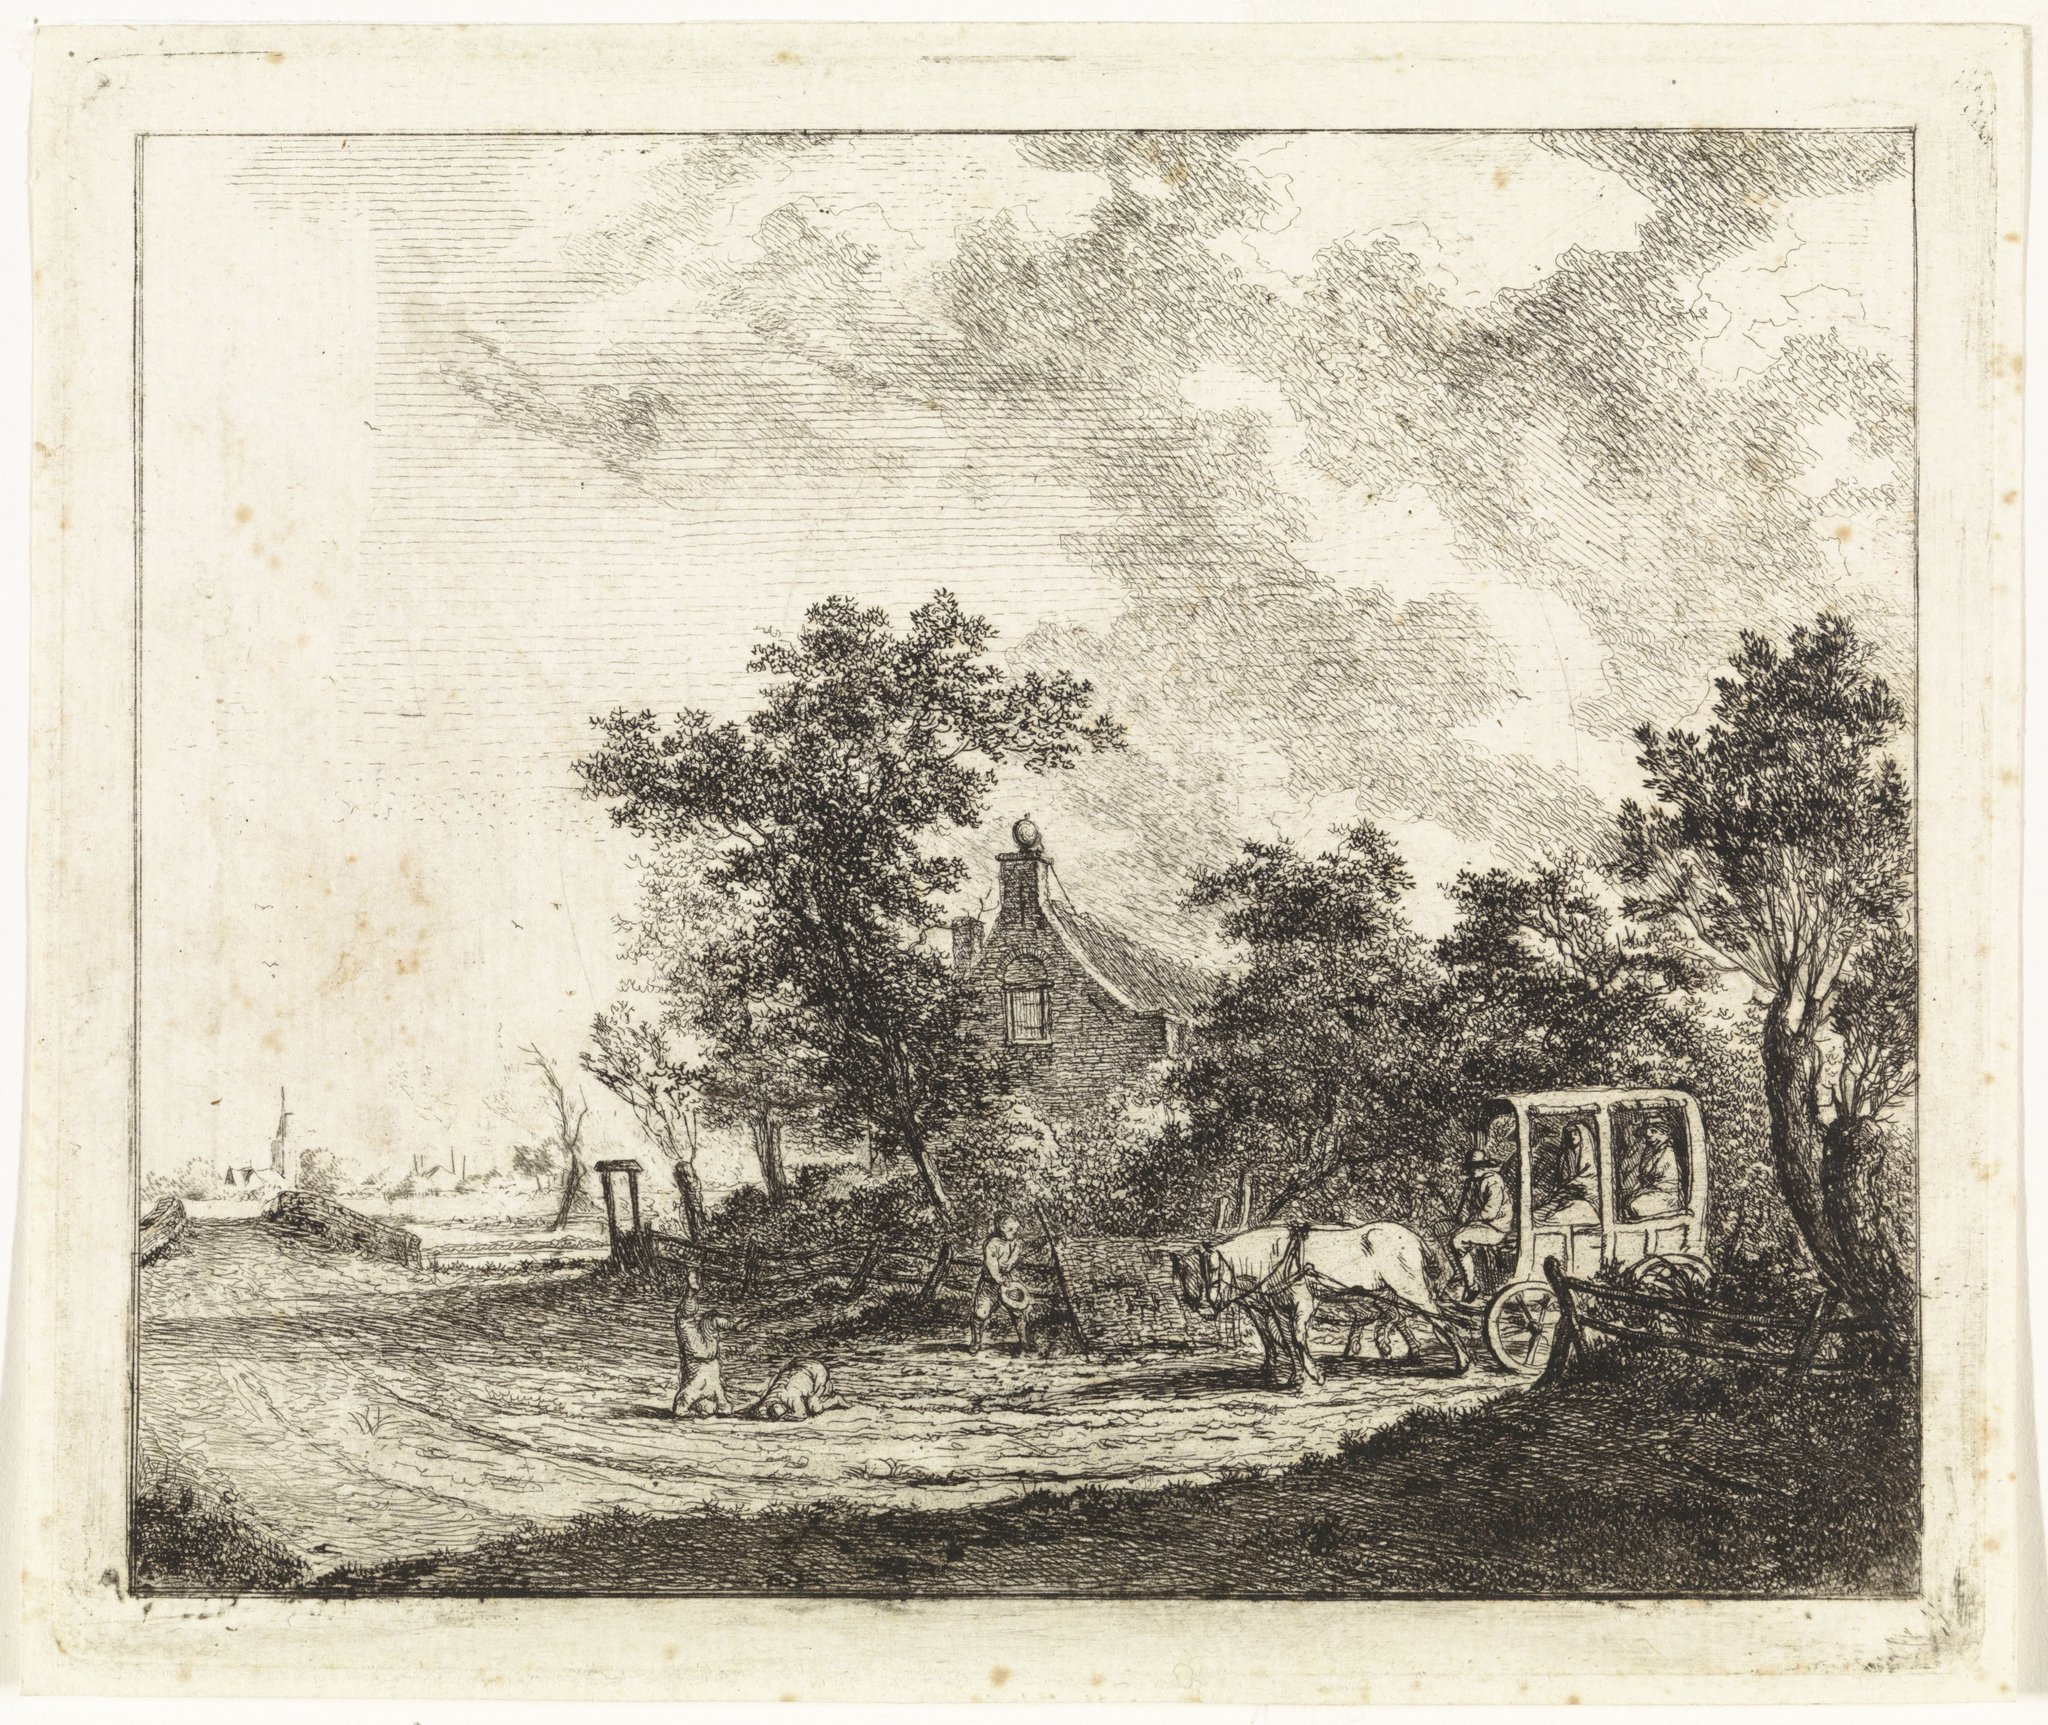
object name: print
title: Paard en wagen voor een huis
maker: Anonymous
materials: paper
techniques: etching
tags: stand on the head ~ jumping games, rural housing, e.g. country-house, villa, cottage, covered wagon, hooded wagon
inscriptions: collector's mark: Lugt 2228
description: Voor een huis rijdt een koets over een weg met daarin enkele reizigers die dekens omgeslagen hebben. Op de weg spelen twee kinderen 'handstand'.